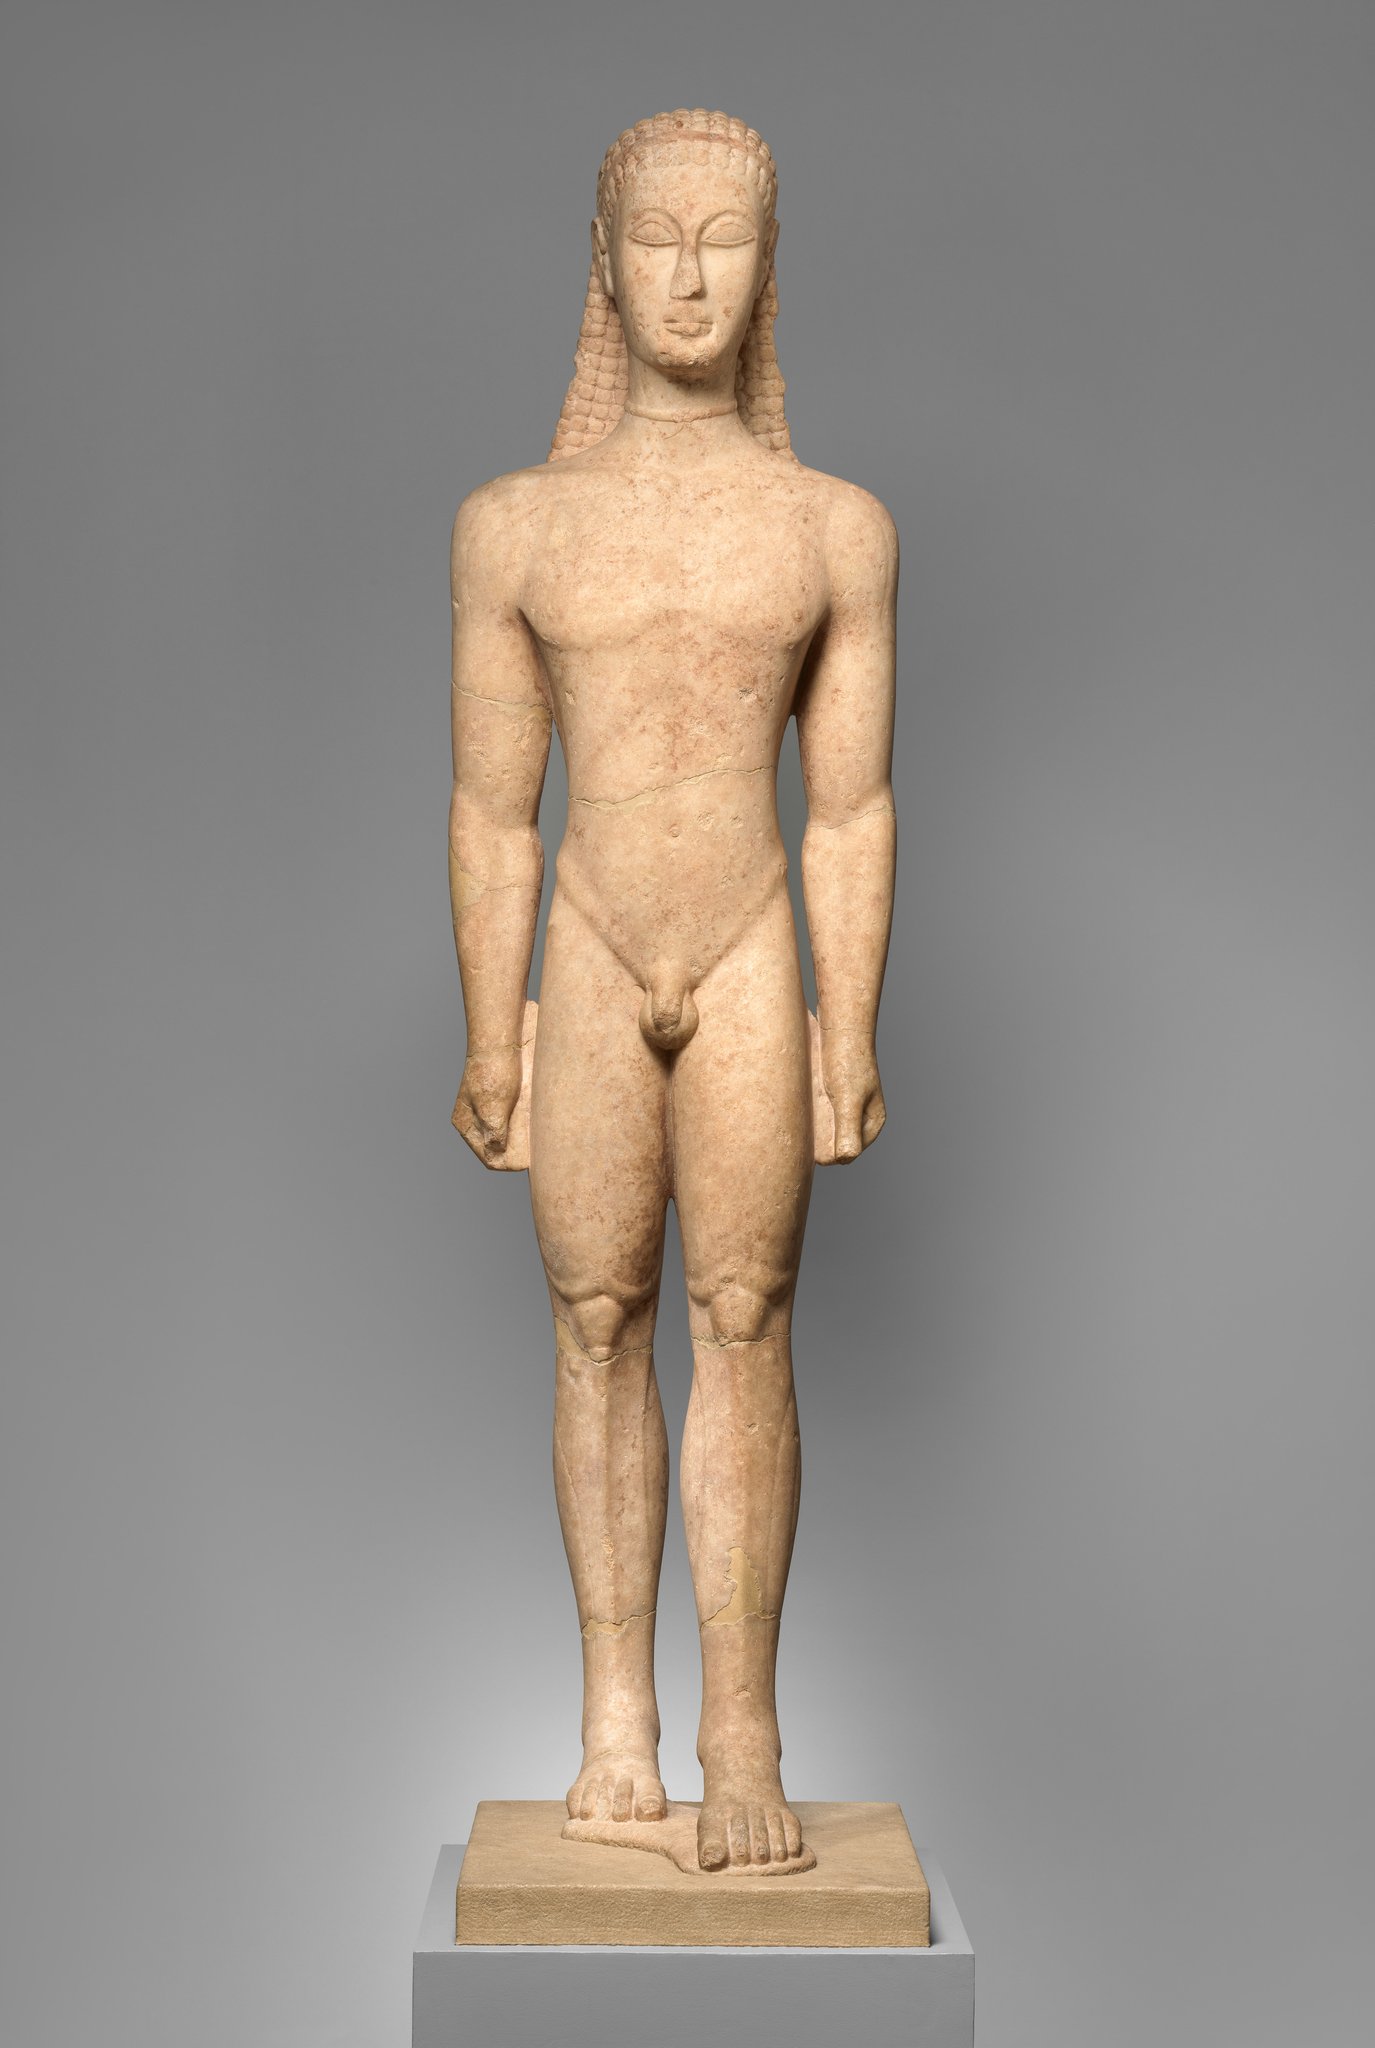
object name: statue of a kouros youth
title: Marble statue of a kouros (youth)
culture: greek, attic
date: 590-580 BCE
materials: marble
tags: male nudes